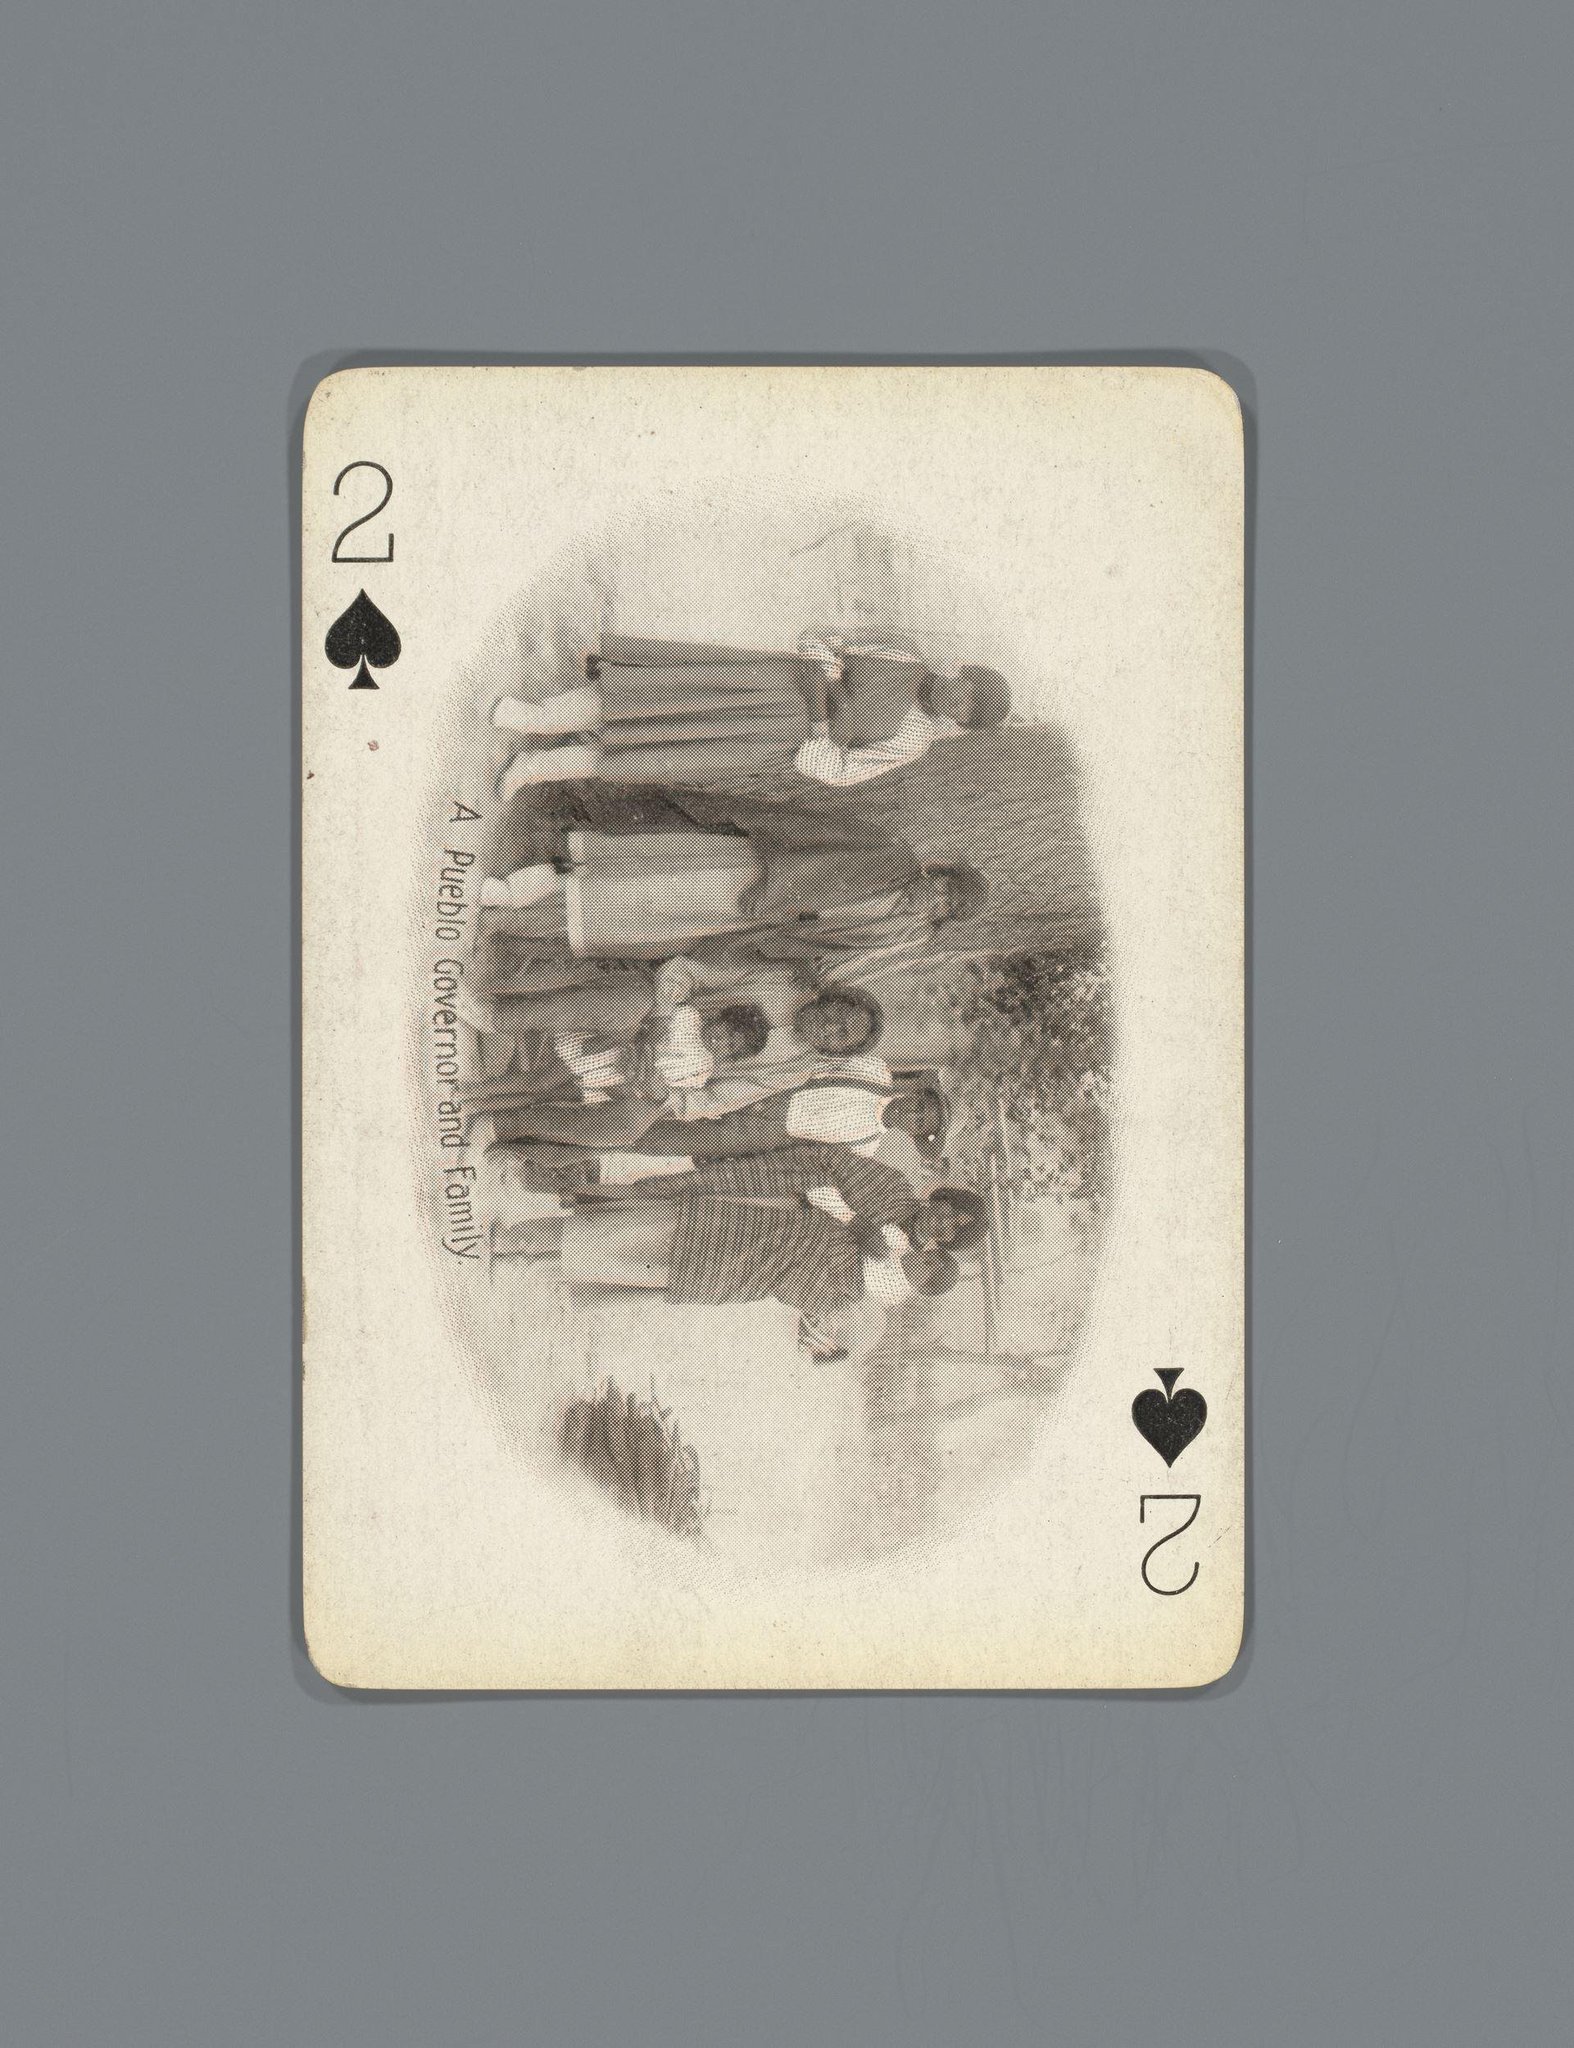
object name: playing card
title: Schoppen twee met portret van de gouverneur van Pueblo of Laguna en zijn gezin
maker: adam clark vroman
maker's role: fotograaf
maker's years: 1856-1916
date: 1900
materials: paper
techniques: autotype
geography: los angeles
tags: united states of america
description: Speelkaart uit doosje met 53 speelkaarten met afbeeldingen in autotypie van Native Americans. De inhoud bevat een complete set speelkaarten inclusief joker.